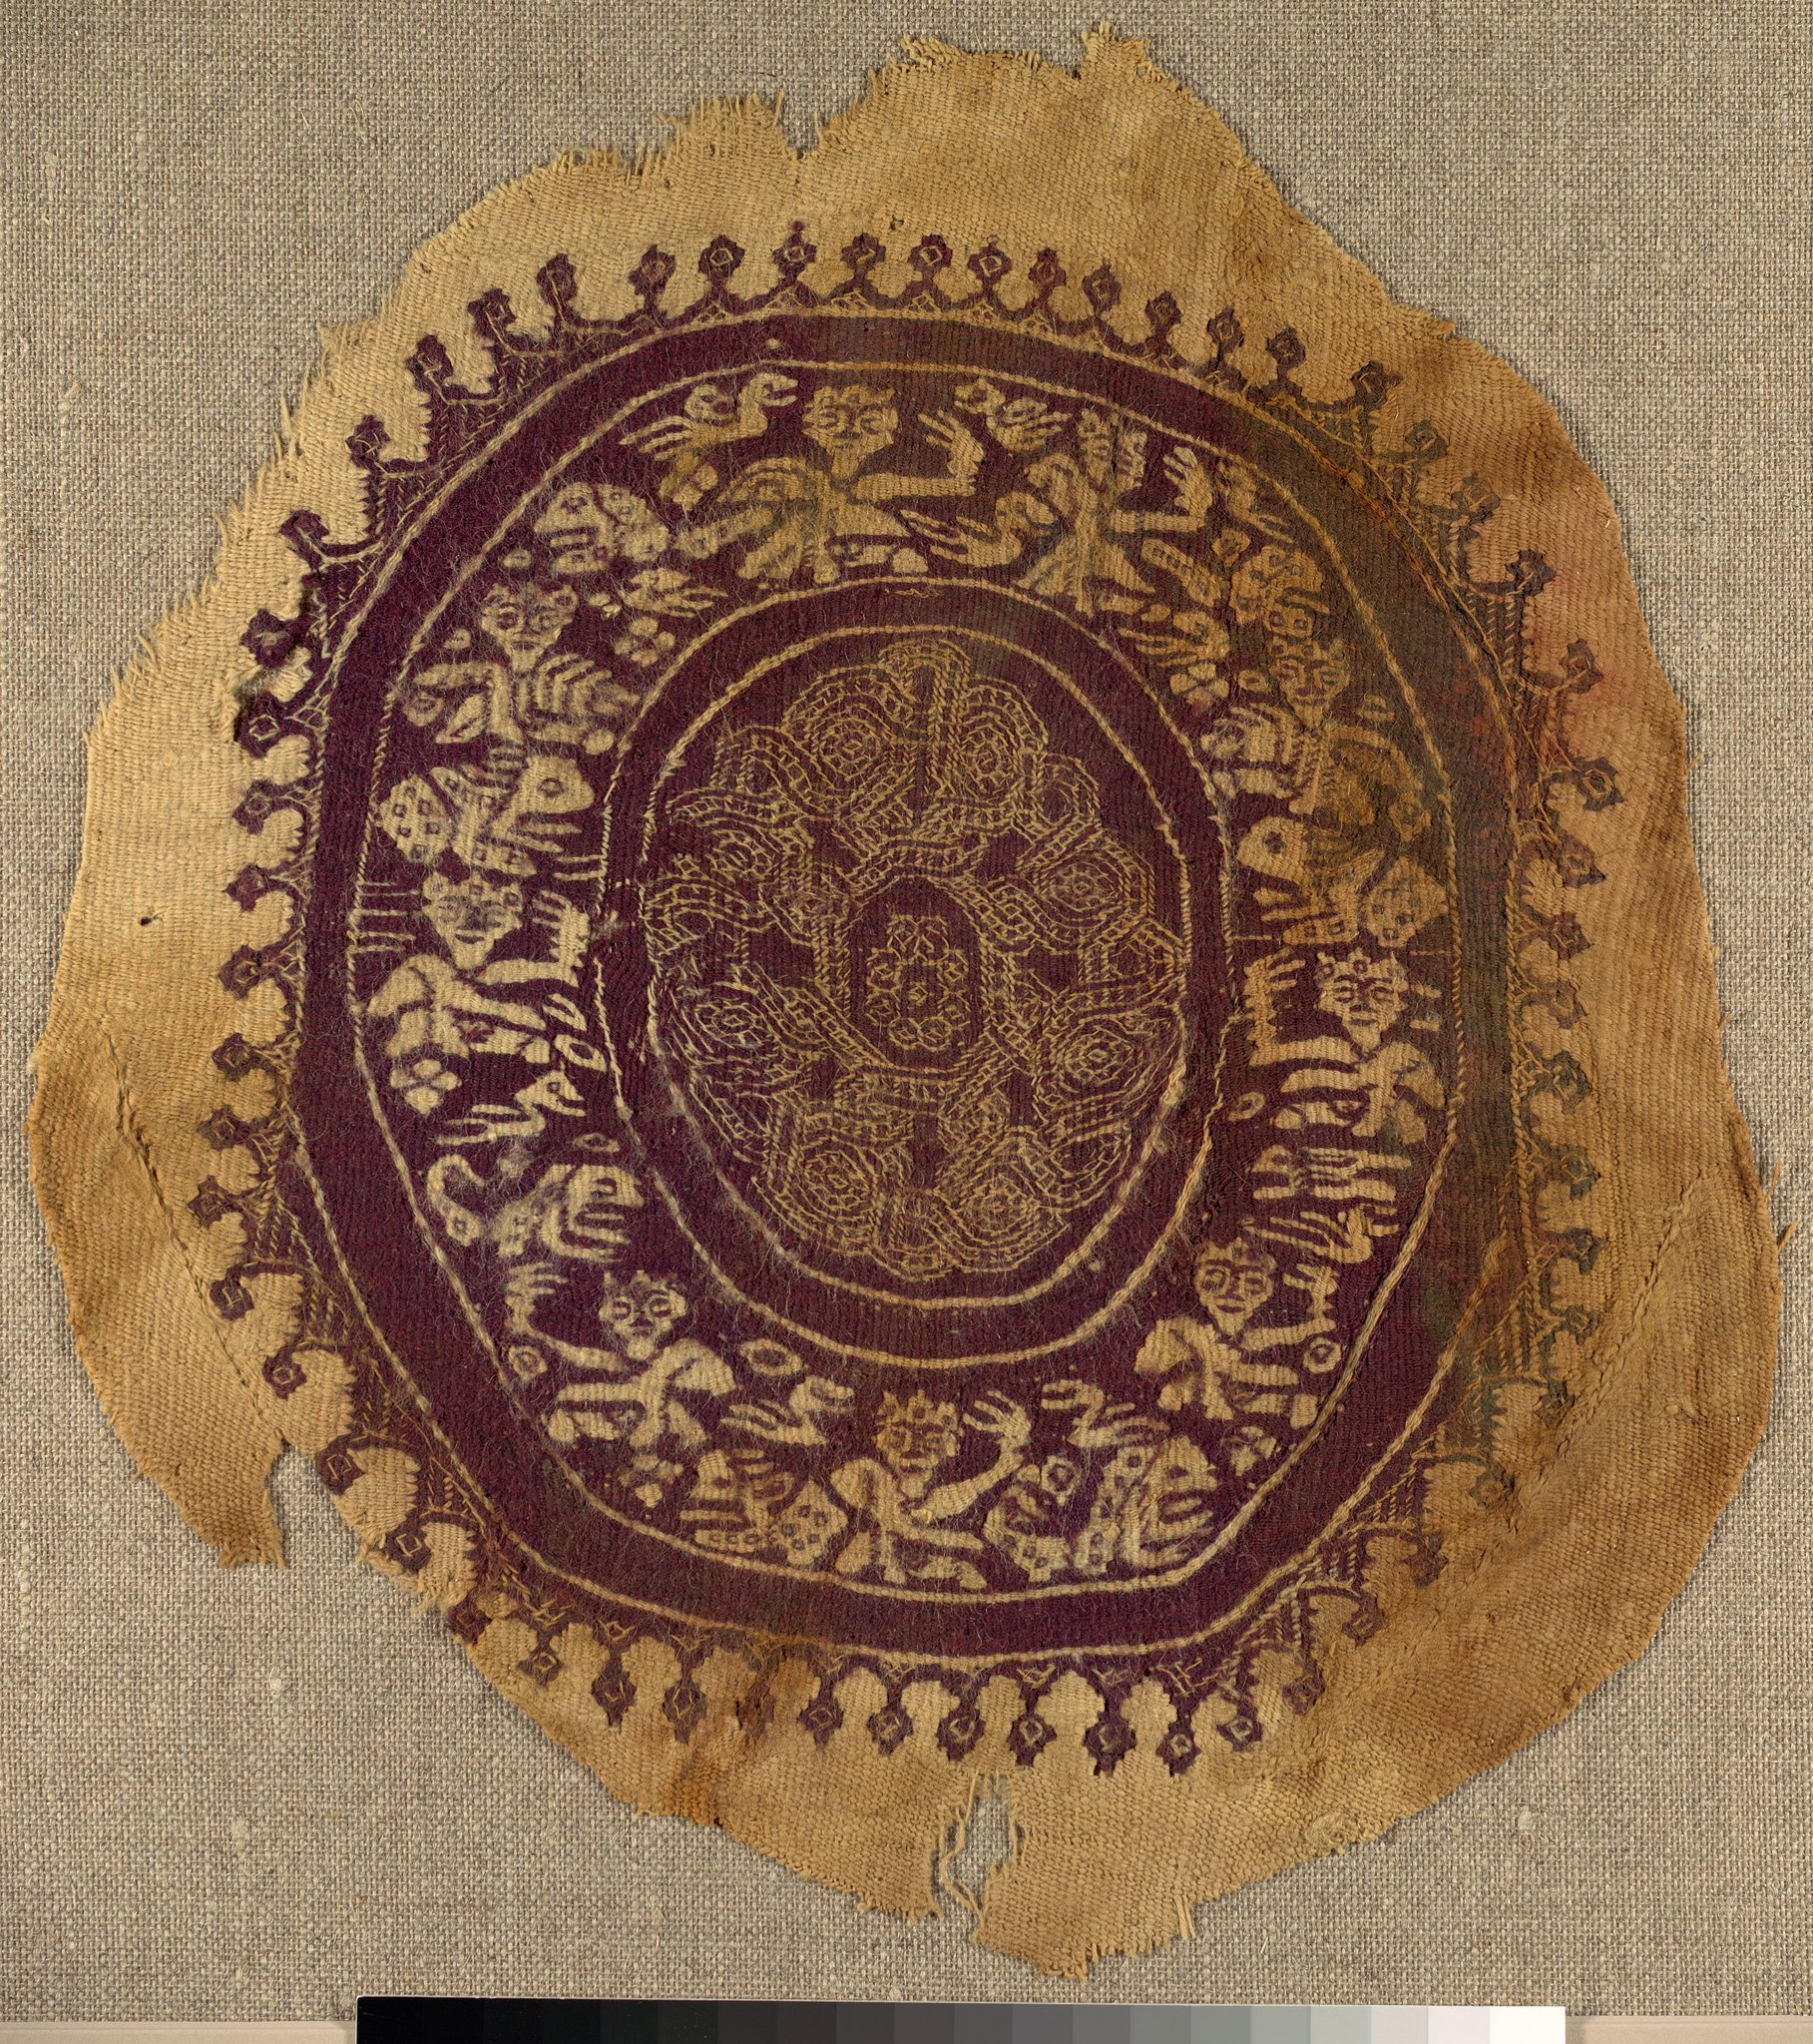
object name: textile fragment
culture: byzantine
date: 701-1000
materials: linen, wool